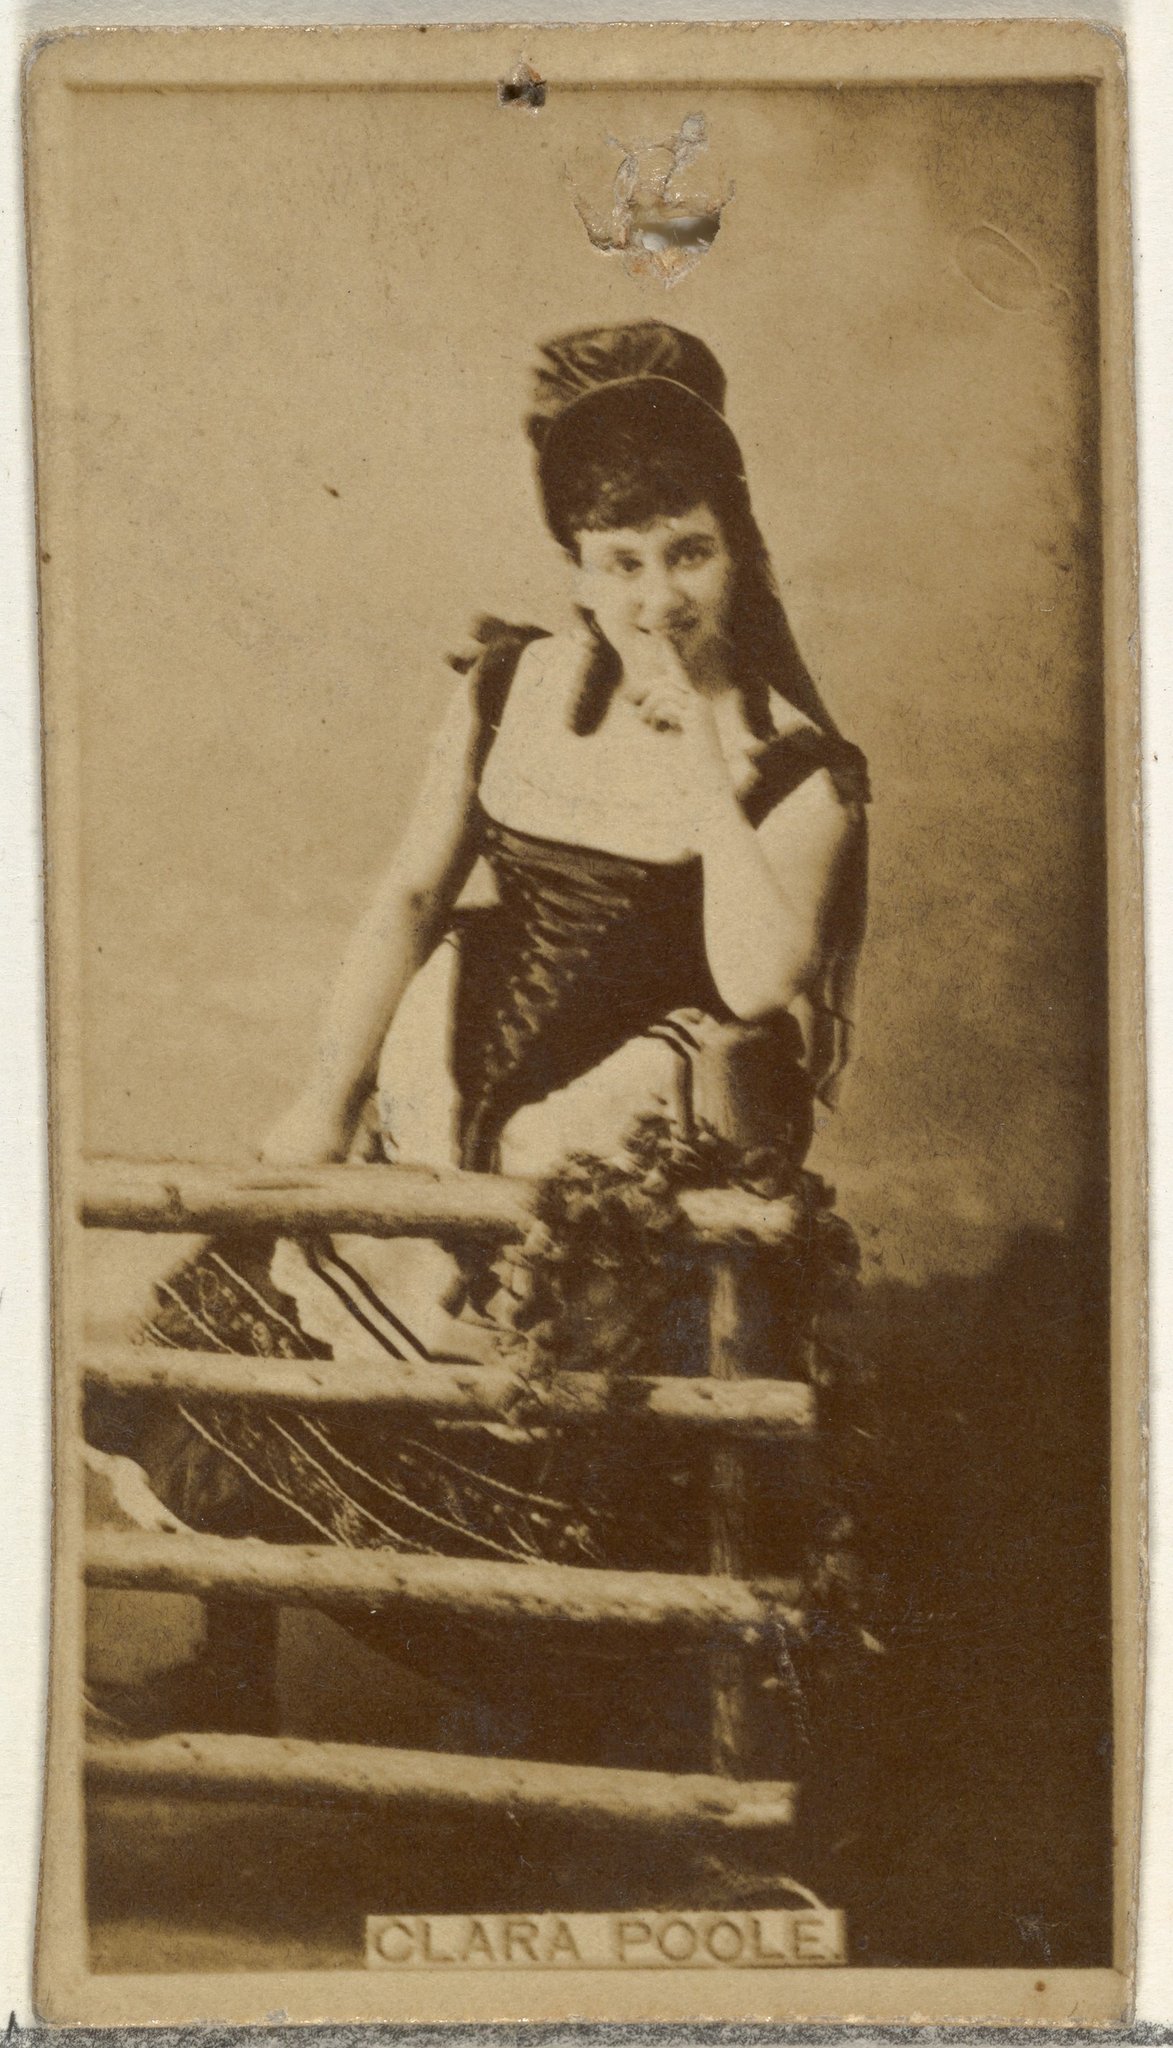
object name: photograph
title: Clara Poole, from the Actors and Actresses series (N145-8) issued by Duke Sons & Co. to promote Duke Cigarettes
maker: w. duke, sons & co.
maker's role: publisher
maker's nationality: american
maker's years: 1870-1920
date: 1891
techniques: albumen silver print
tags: portraits,women,actresses